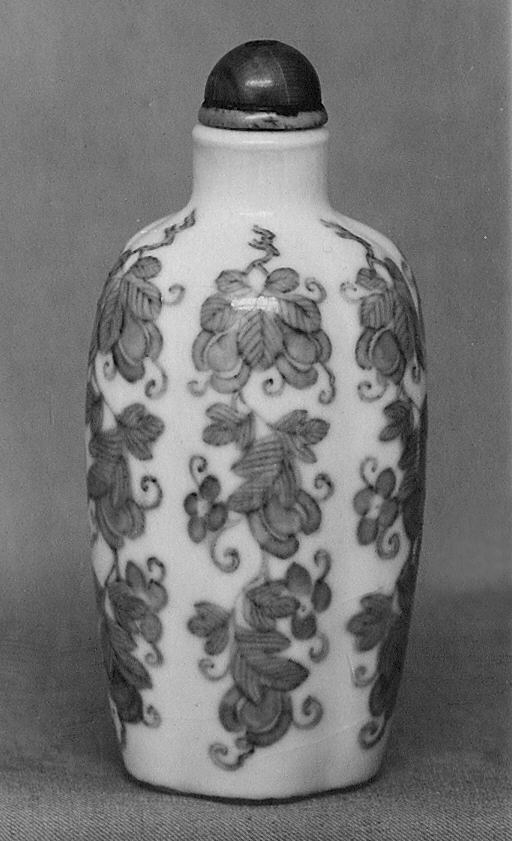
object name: snuff bottle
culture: chinese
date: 1662-1722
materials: porcelain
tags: flowers